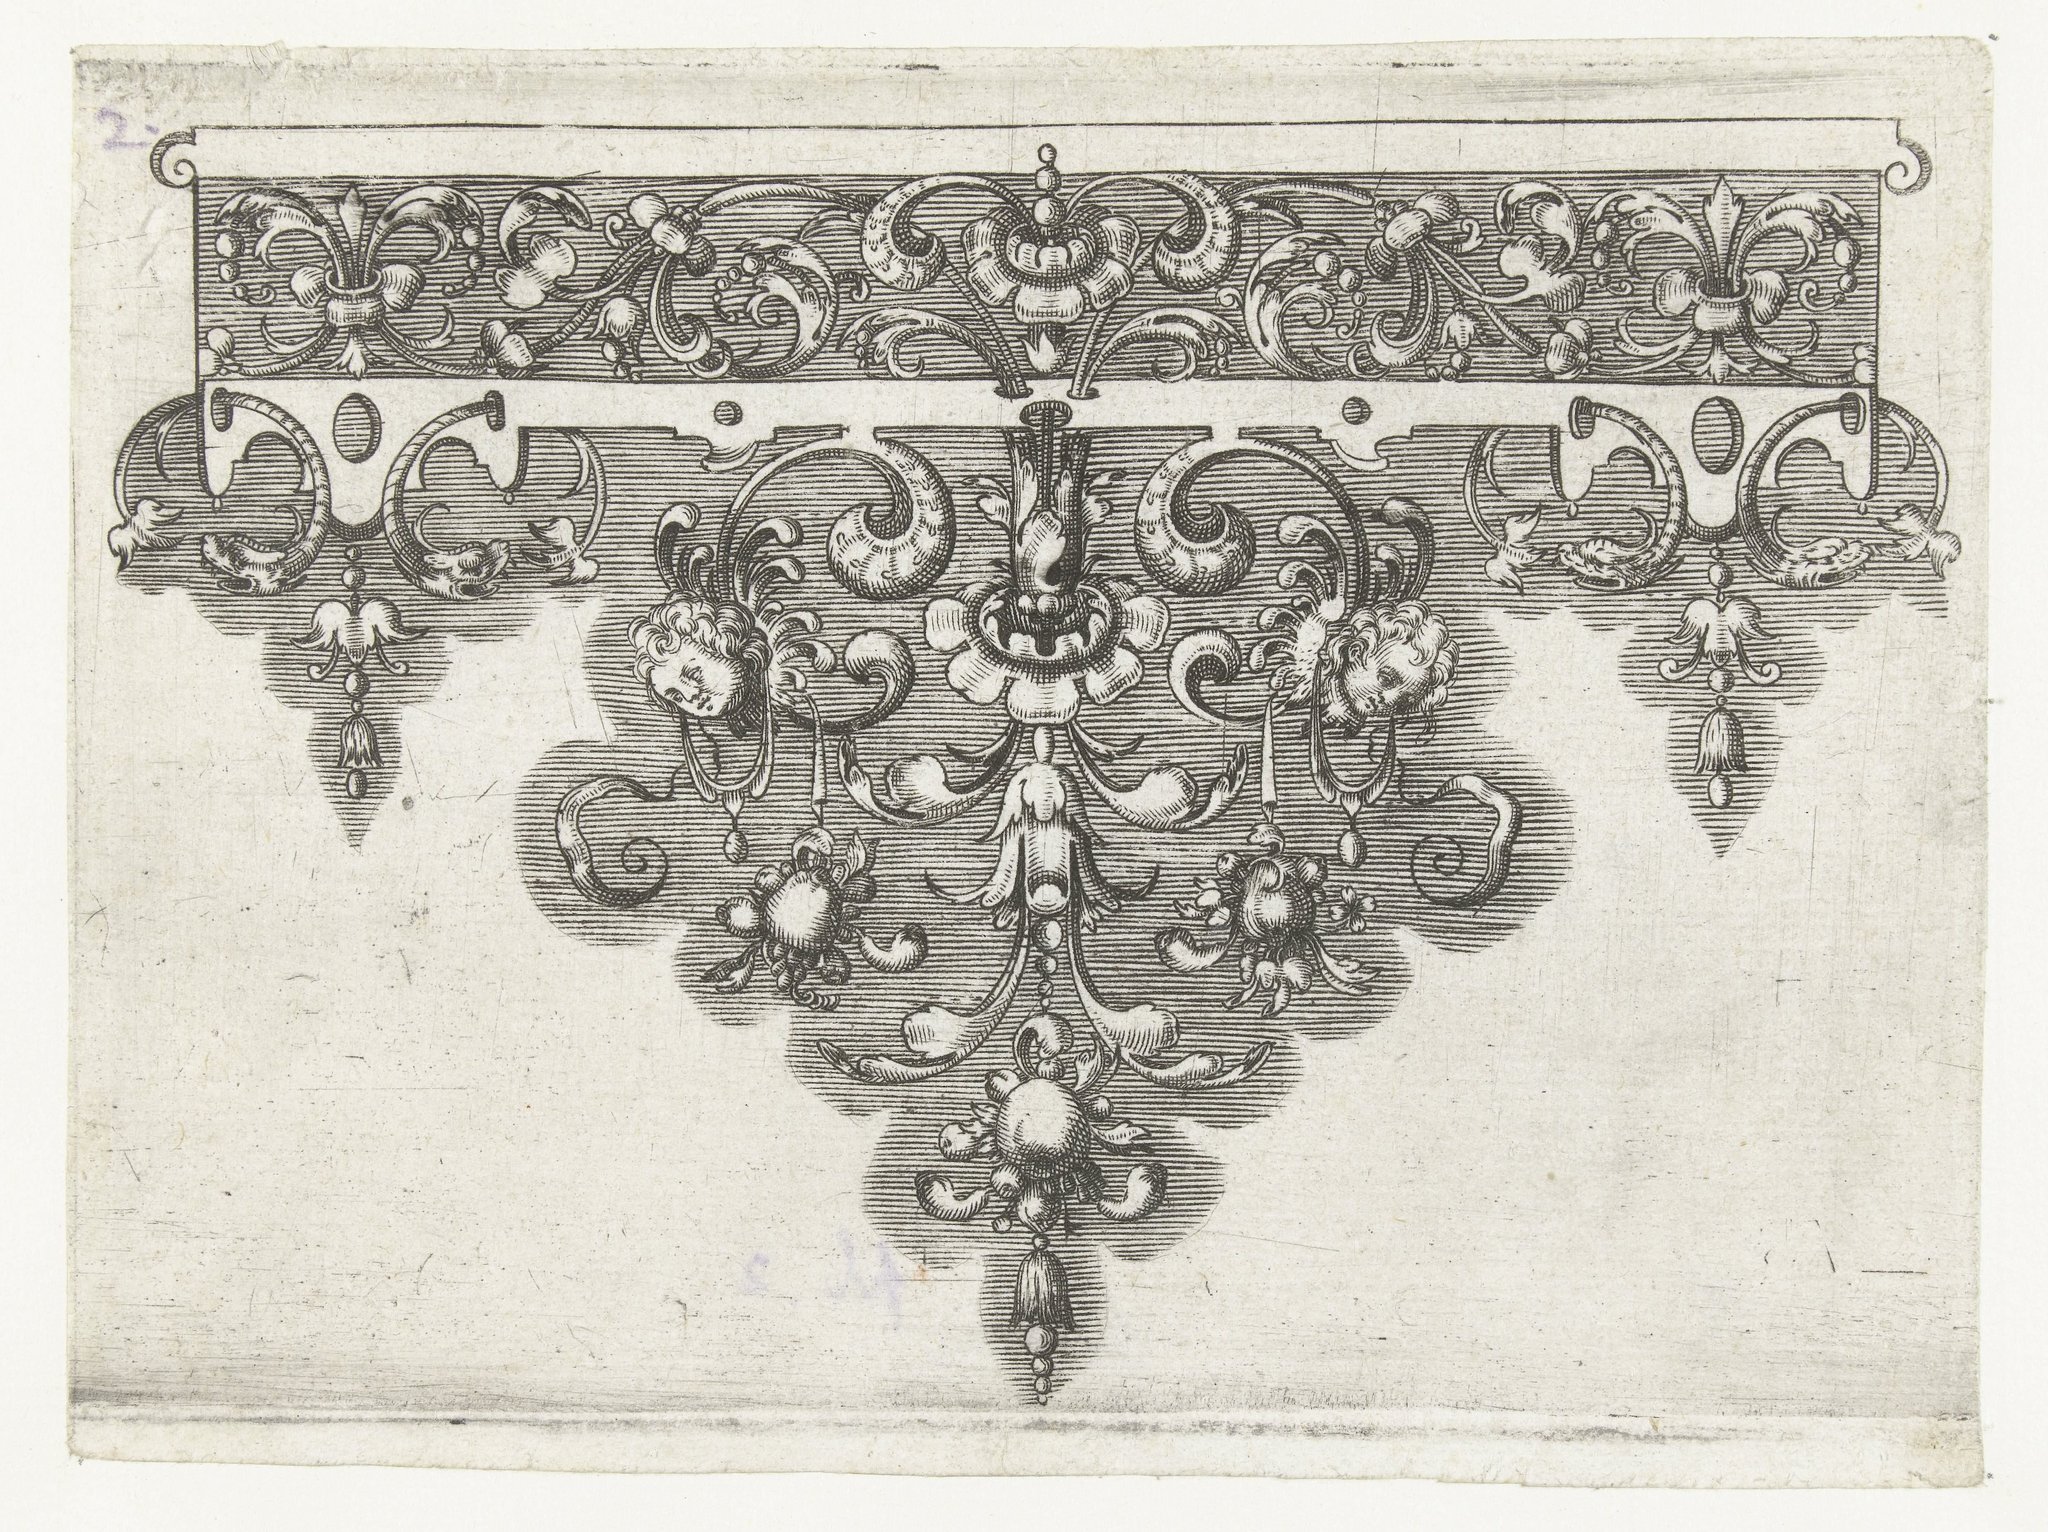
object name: print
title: Kopieën naar prenten met decoratie voor randen en bekers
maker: Anonymous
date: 1571-1639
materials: paper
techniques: engraving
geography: germany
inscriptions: inscription: ‘2’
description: Fries met bladranken, afkomstig uit de plant in het midden van de decoratie daaronder. Aan weerszijden van de plant zweeft een cherubijntje. Eén van 3 bladen. Kopieën naar de prenten van de onder Orn Cat I-317 beschreven serie.